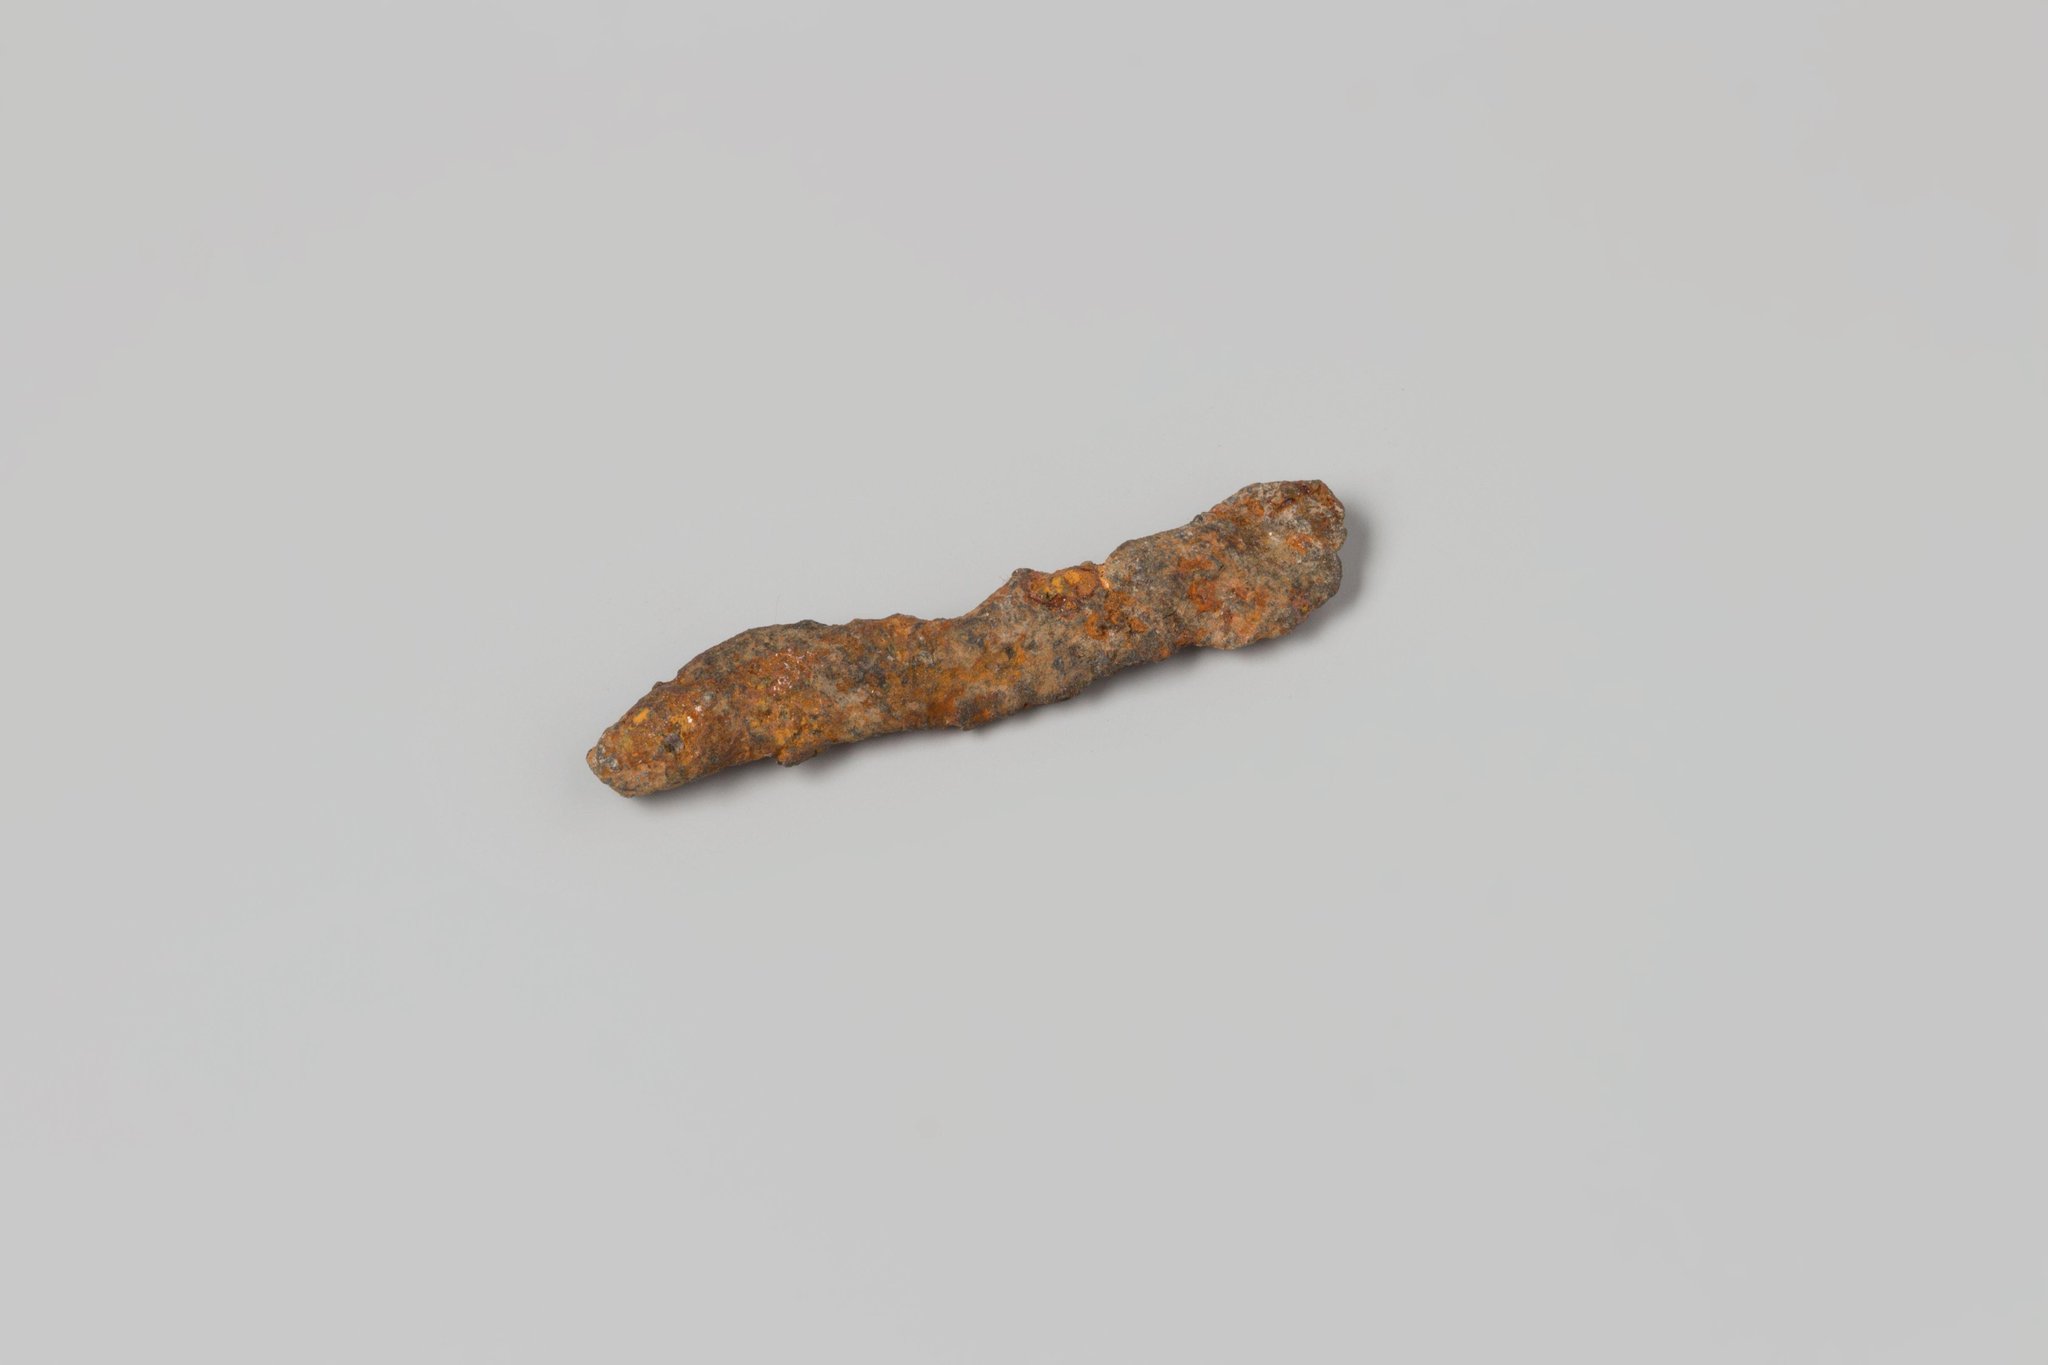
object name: scheepswrakvondst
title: Scheepswrakvondst uit het wrak van de Oost-Indiëvaarder Hollandia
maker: Anonymous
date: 1700-1743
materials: lead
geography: netherlands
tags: verenigde oostindische compagnie, hollandia (schip), annet